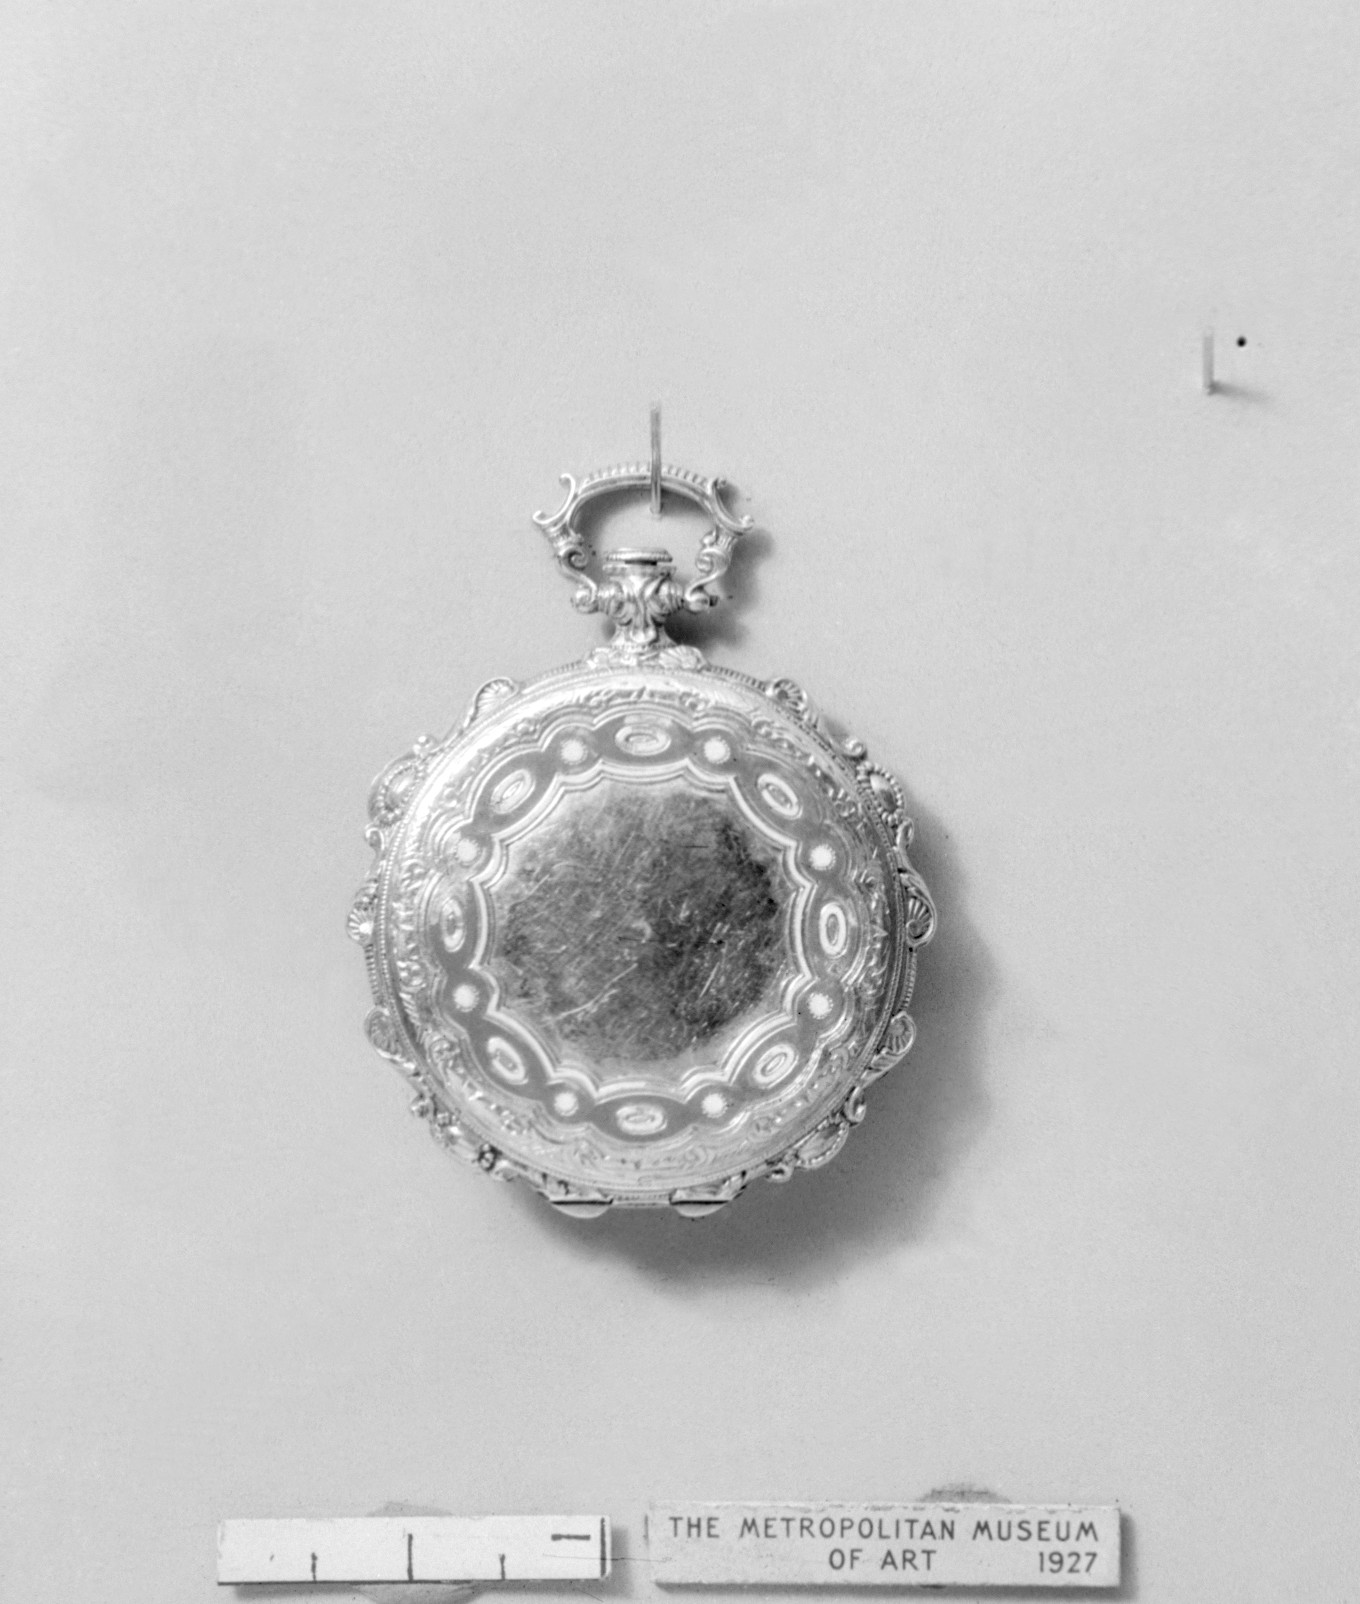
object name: watch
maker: le quin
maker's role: maker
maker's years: 1800-1900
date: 1830-1840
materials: enamel, gold, steel